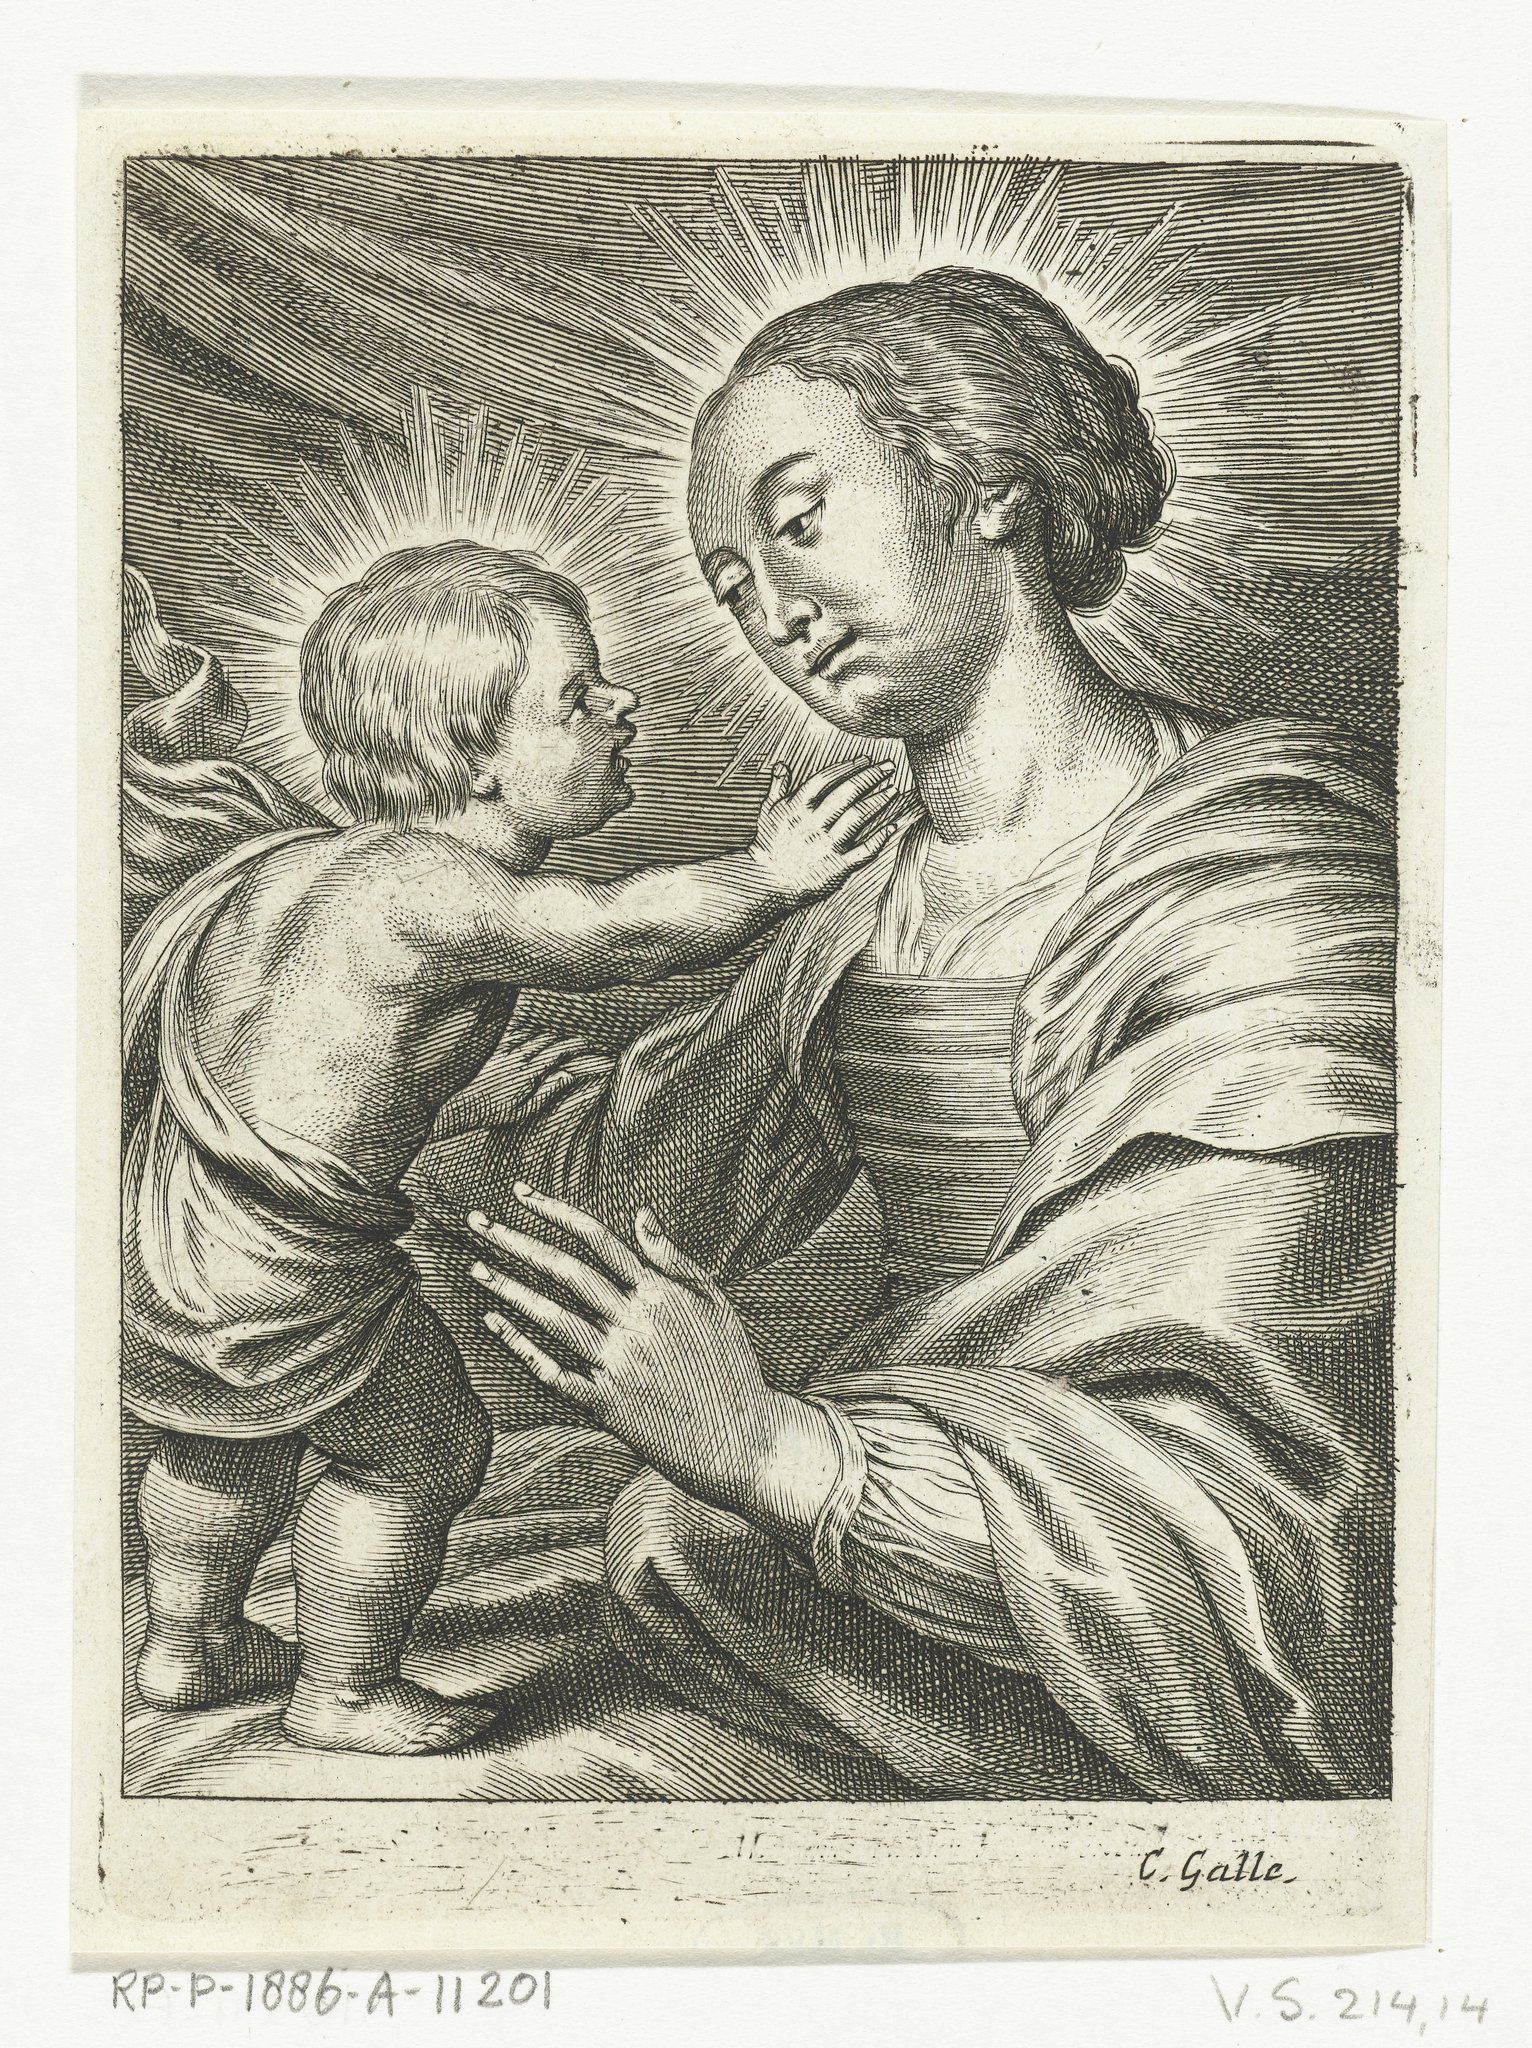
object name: print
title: Vélins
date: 1596-1678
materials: paper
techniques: engraving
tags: mary sitting or enthroned, the christ-child standing on her knee (christ-child to mary's left)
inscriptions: collector's mark: Lugt 2228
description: Prent uit serie Vélins met negentig prenten naar ontwerp van Peter Paul Rubens. In de bronnen vinden we uiteenlopende gegevens over aantal en samenstelling van de serie. Hollstein hanteert het aantal van negentig prenten. De reeks Vélins in de collectie van het RMA bevat verschillende staten afkomstig uit meerdere uitgaven welke moeilijk te duiden zijn. Sommige dragen het originele adres van Schelte Adamsz. Bolswert als graveur en uitgever, op andere exemplaren is deze naam verwijderd (duidelijk zichtbaar!) en vervangen door de naam Cornelis Galle (II). De prenten met de naam van uitgever Galle zijn vaak opgewerkt. We treffen nog een andere naam van een uitgever bij enkele prent aan: Martien van den Enden. Herkomst uit meerdere uitgaven spreekt ook uit afwijkende opschriften in Nederlands en Latijn en variaties op dezelfde thema's welke misschien nooit langs elkaar in dezelfde serie gebruikt werden.